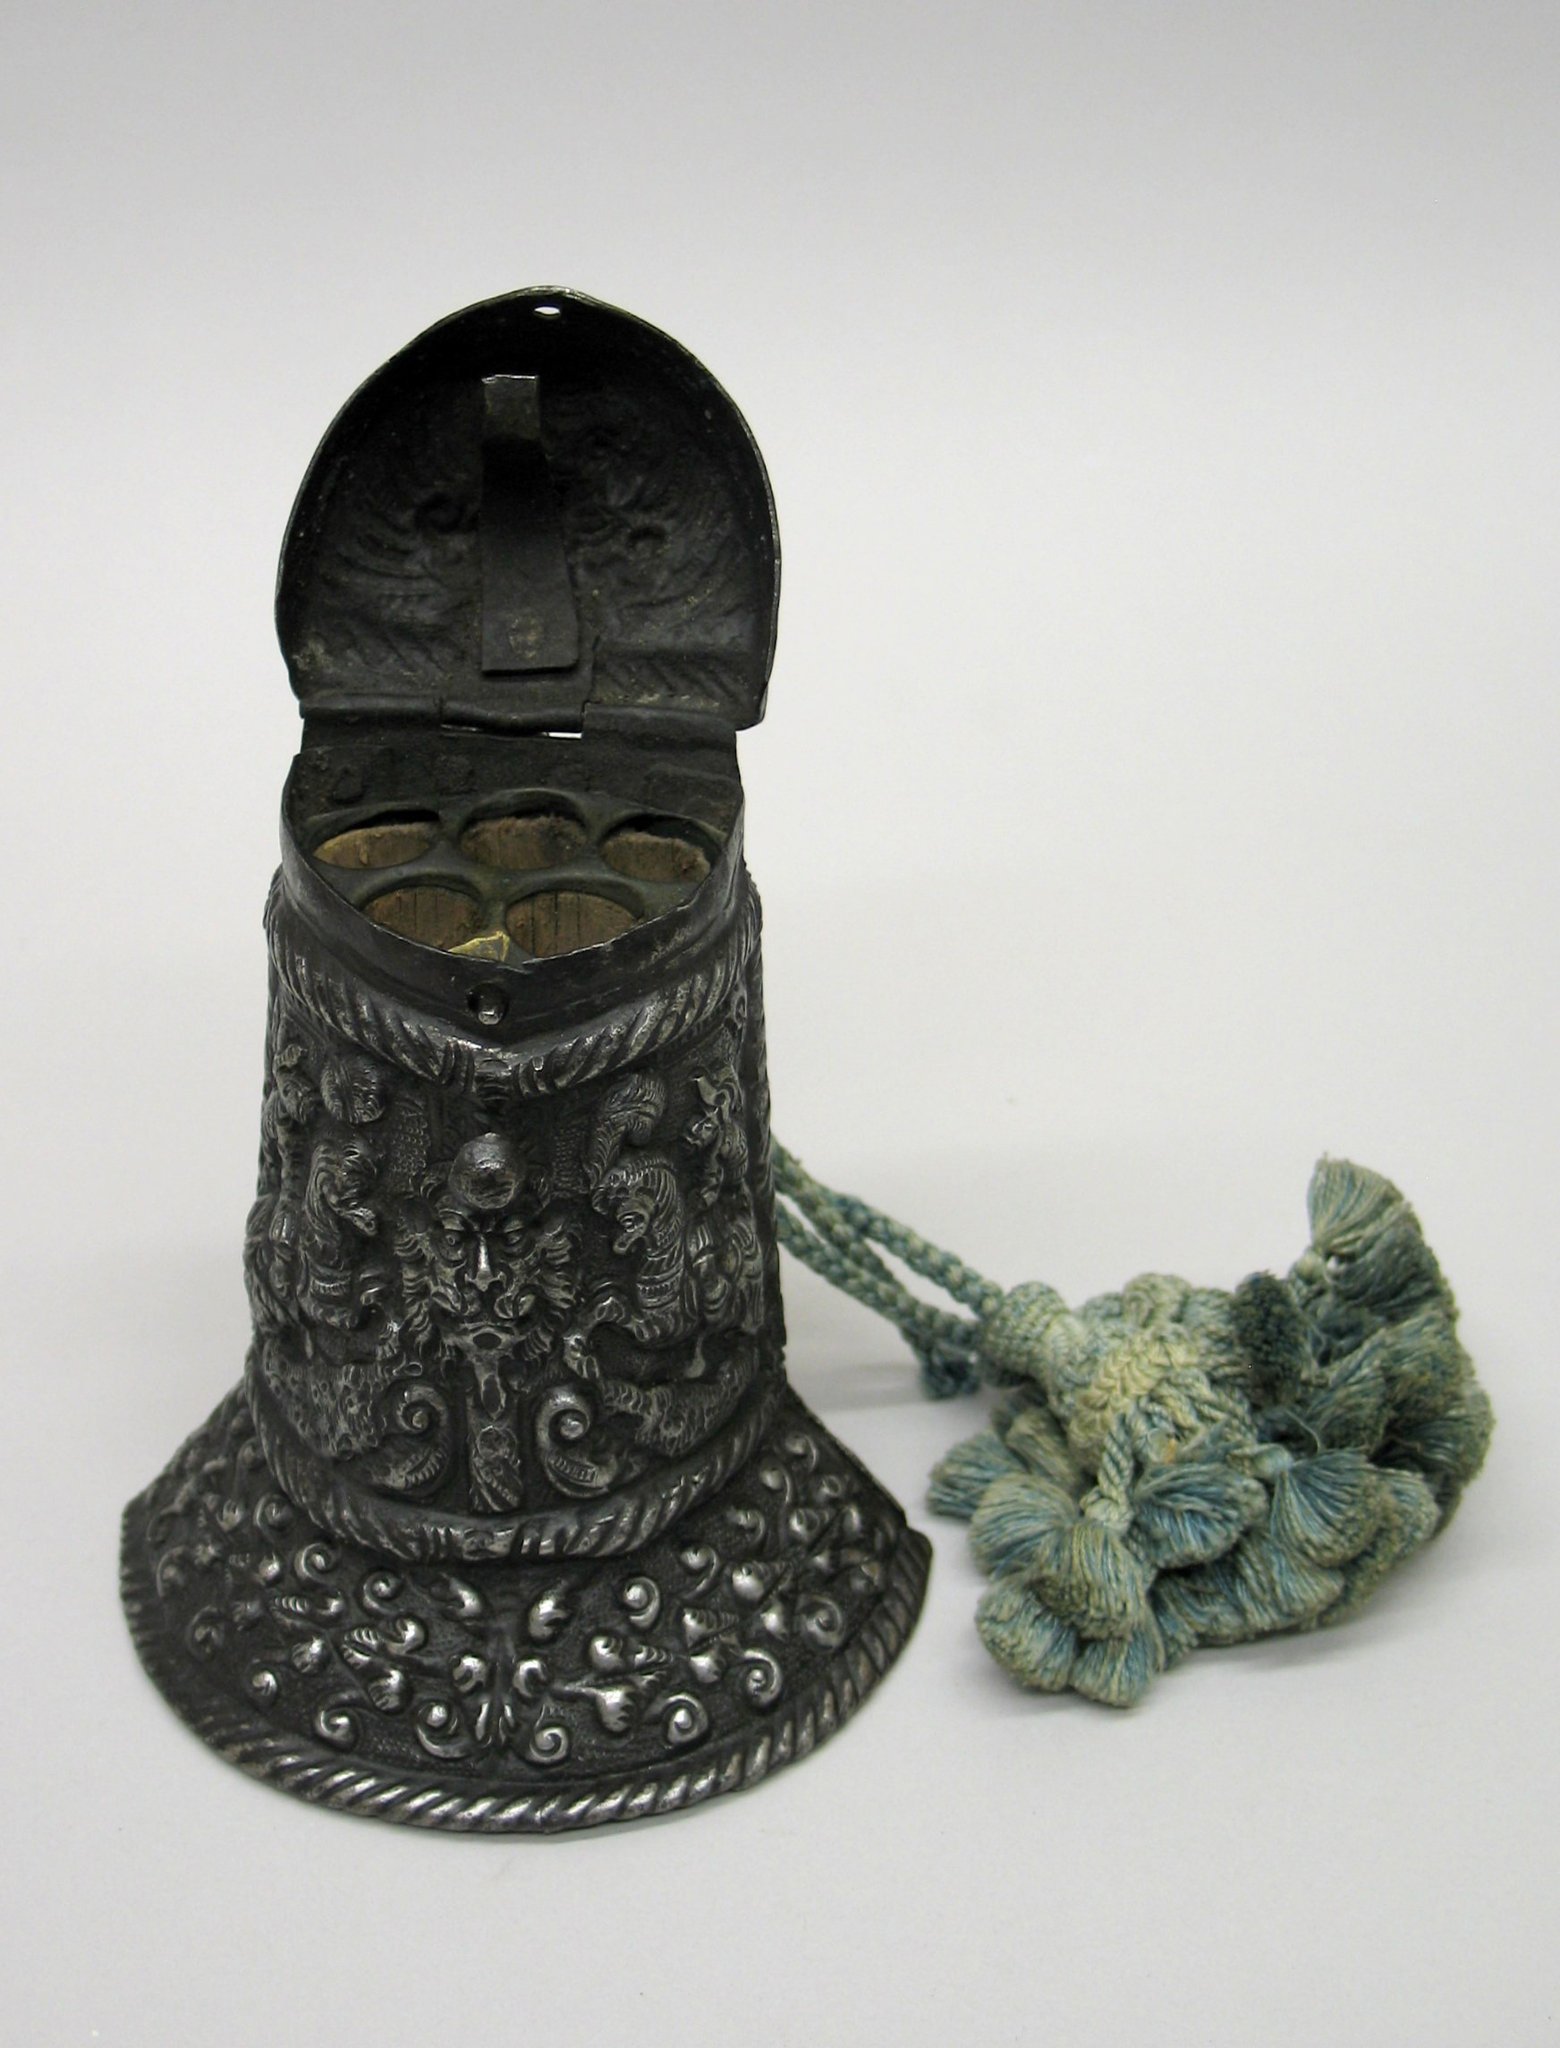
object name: cartridge box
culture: german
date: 1575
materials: iron, leather, textile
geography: germany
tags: horses